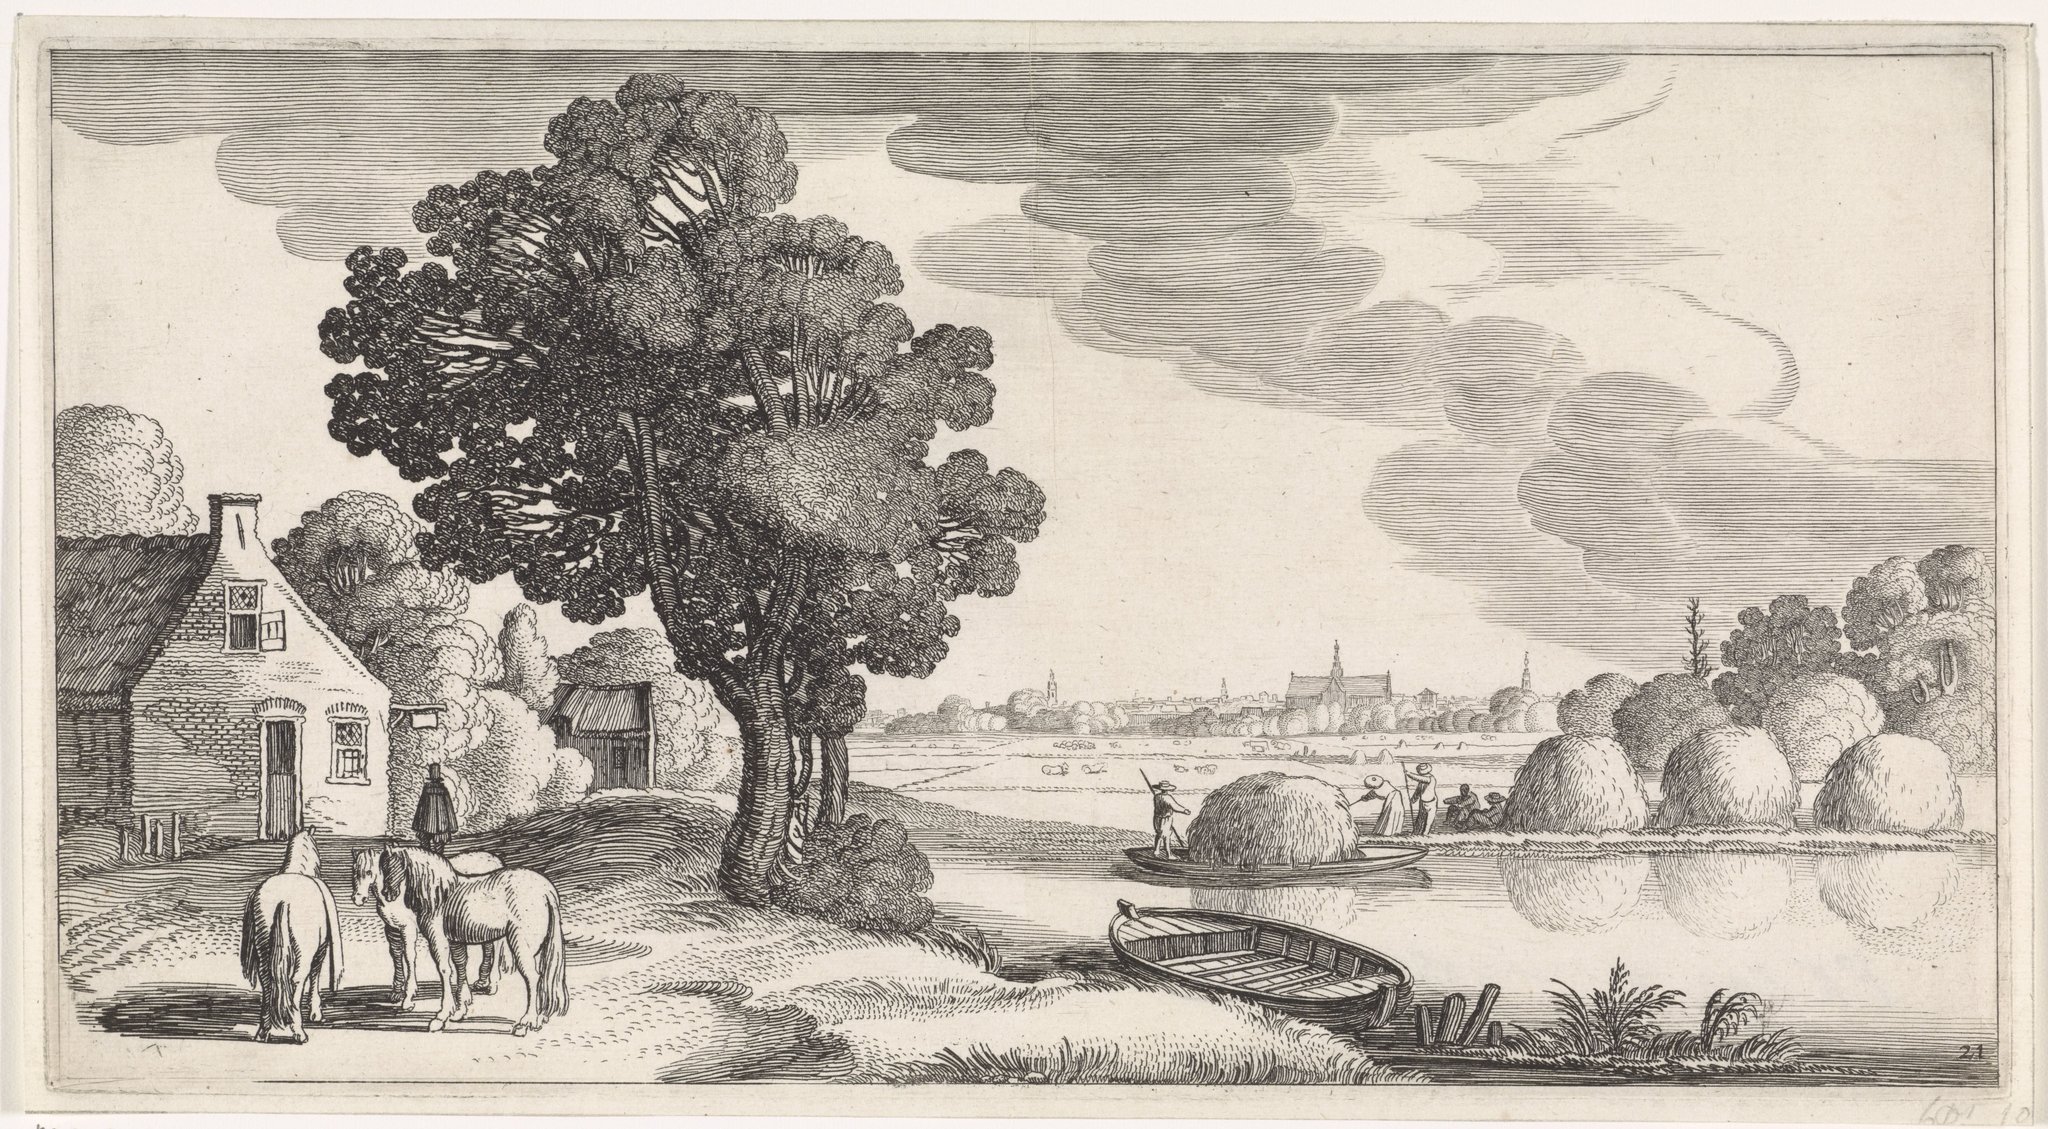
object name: print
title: Transport van hooi op een rivier met Haarlem in de verte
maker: jan van de velde (ii)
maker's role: draughtsman, painter, print maker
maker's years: 1593-1641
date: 1639-1641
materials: paper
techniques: etching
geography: northern netherlands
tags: agricultural products and by-products: hay, river, transporting ~ harvest, horse, hay-stack, haarlem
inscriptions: collector's mark: Lugt 964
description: Transport van hooi op een rivier. Op het water een hooischuit en aan de oever figuren bij drie hooibergen. Links een huis en een figuur en drie paarden op een pad. Aan de horizon Haarlem met onder andere de Sint-Bavokerk. Eenentwintigste prent van een serie met 36 prenten van landschappen, verdeeld over zes delen.